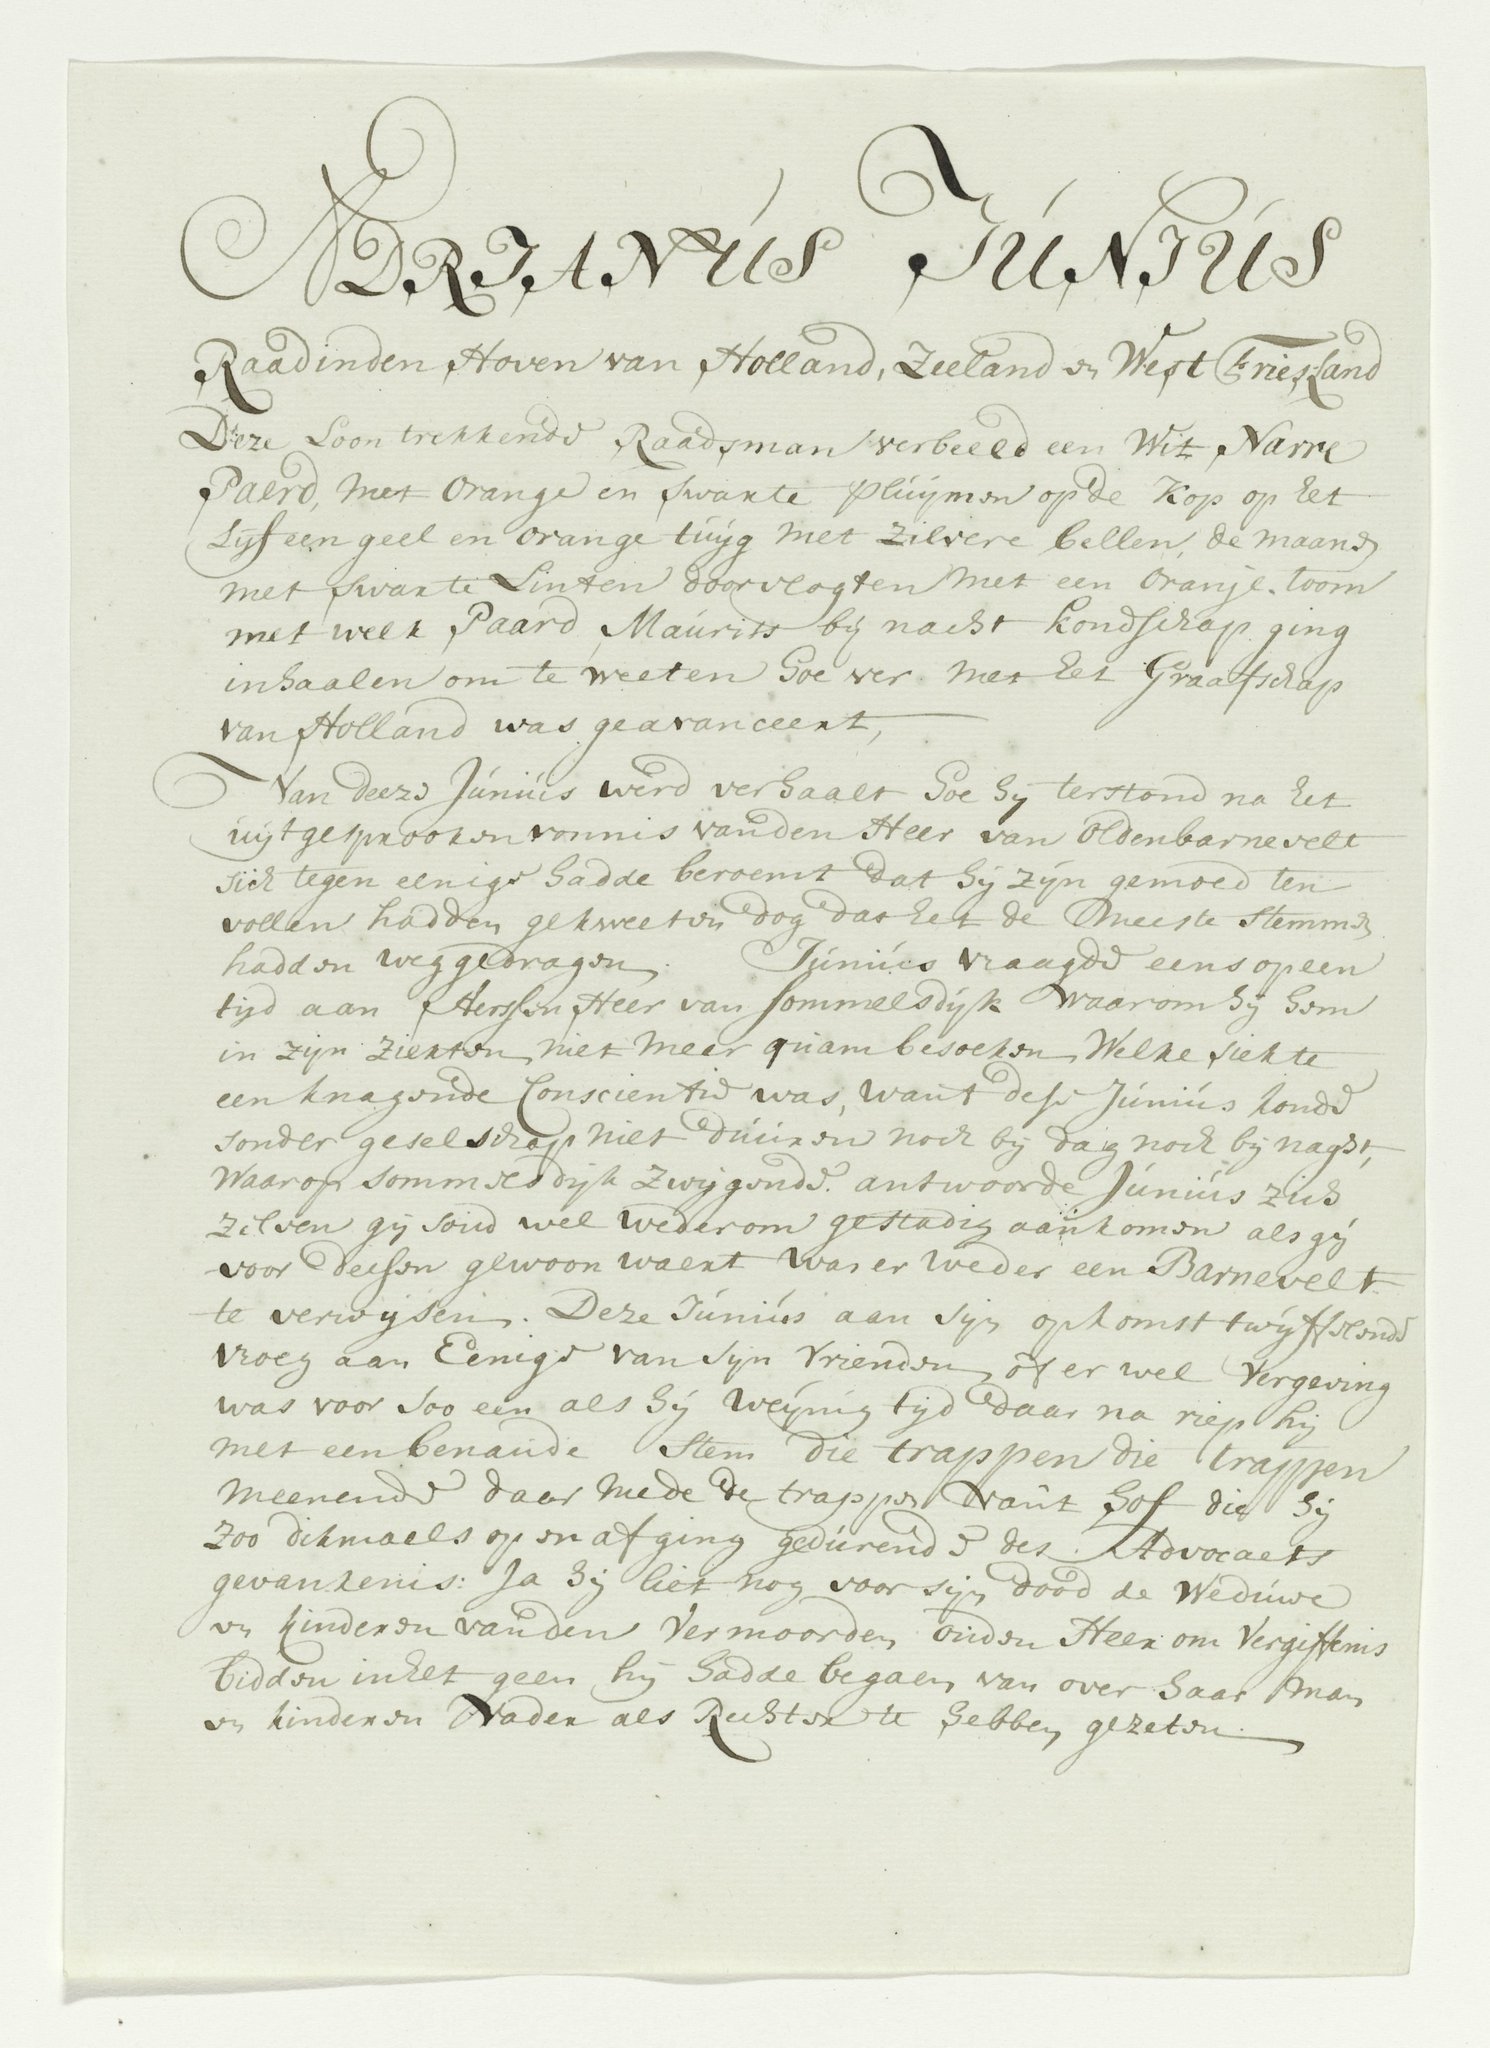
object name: poem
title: Spotvers bij het portret van Adrianus Junius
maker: Anonymous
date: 1710-1720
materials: paper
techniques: pen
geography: netherlands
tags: johan van oldenbarnevelt, dordrecht, politician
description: Spotprent van Adrianus Junius, rechter van Van Oldenbarnevelt. Wit paard met pluimen en dekkleed, op de borst een wapen, in krans van bloemen en bladeren. Daaronder cartouche met daarin naam en daarboven nr. 4. Onderin cartouche een beker. Behorende bij serie aquarellen in boek.